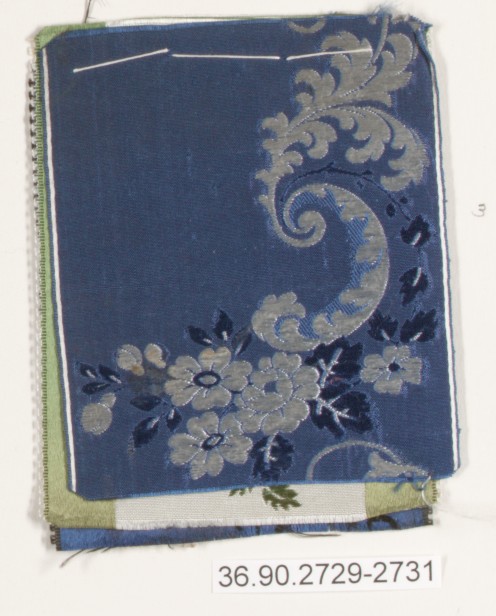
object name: ribbon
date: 1801-1900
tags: flowers